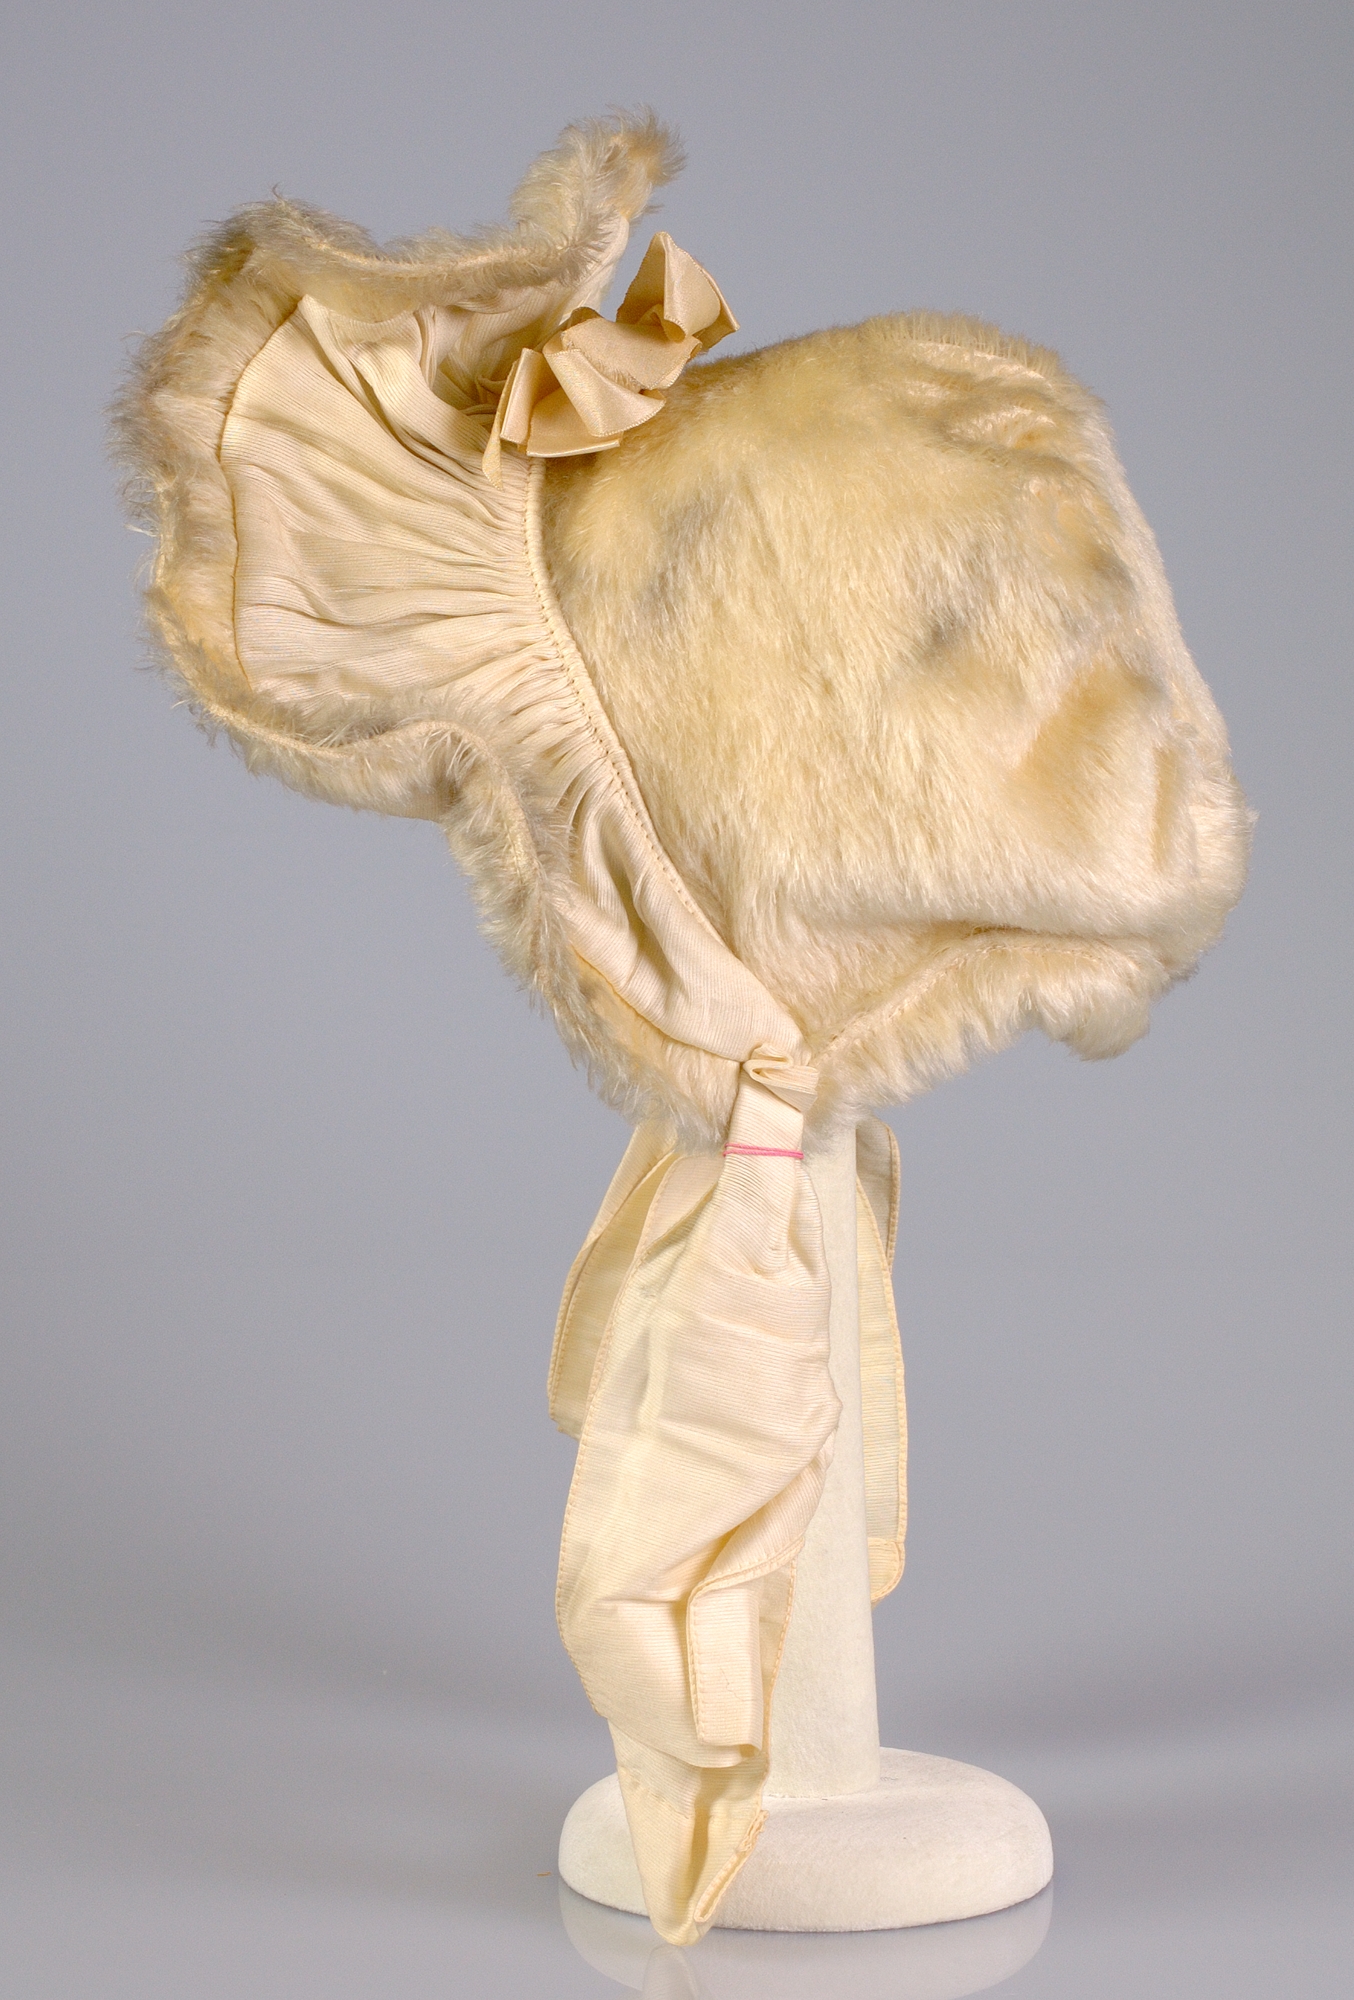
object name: bonnet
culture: american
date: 1895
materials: silk, wool